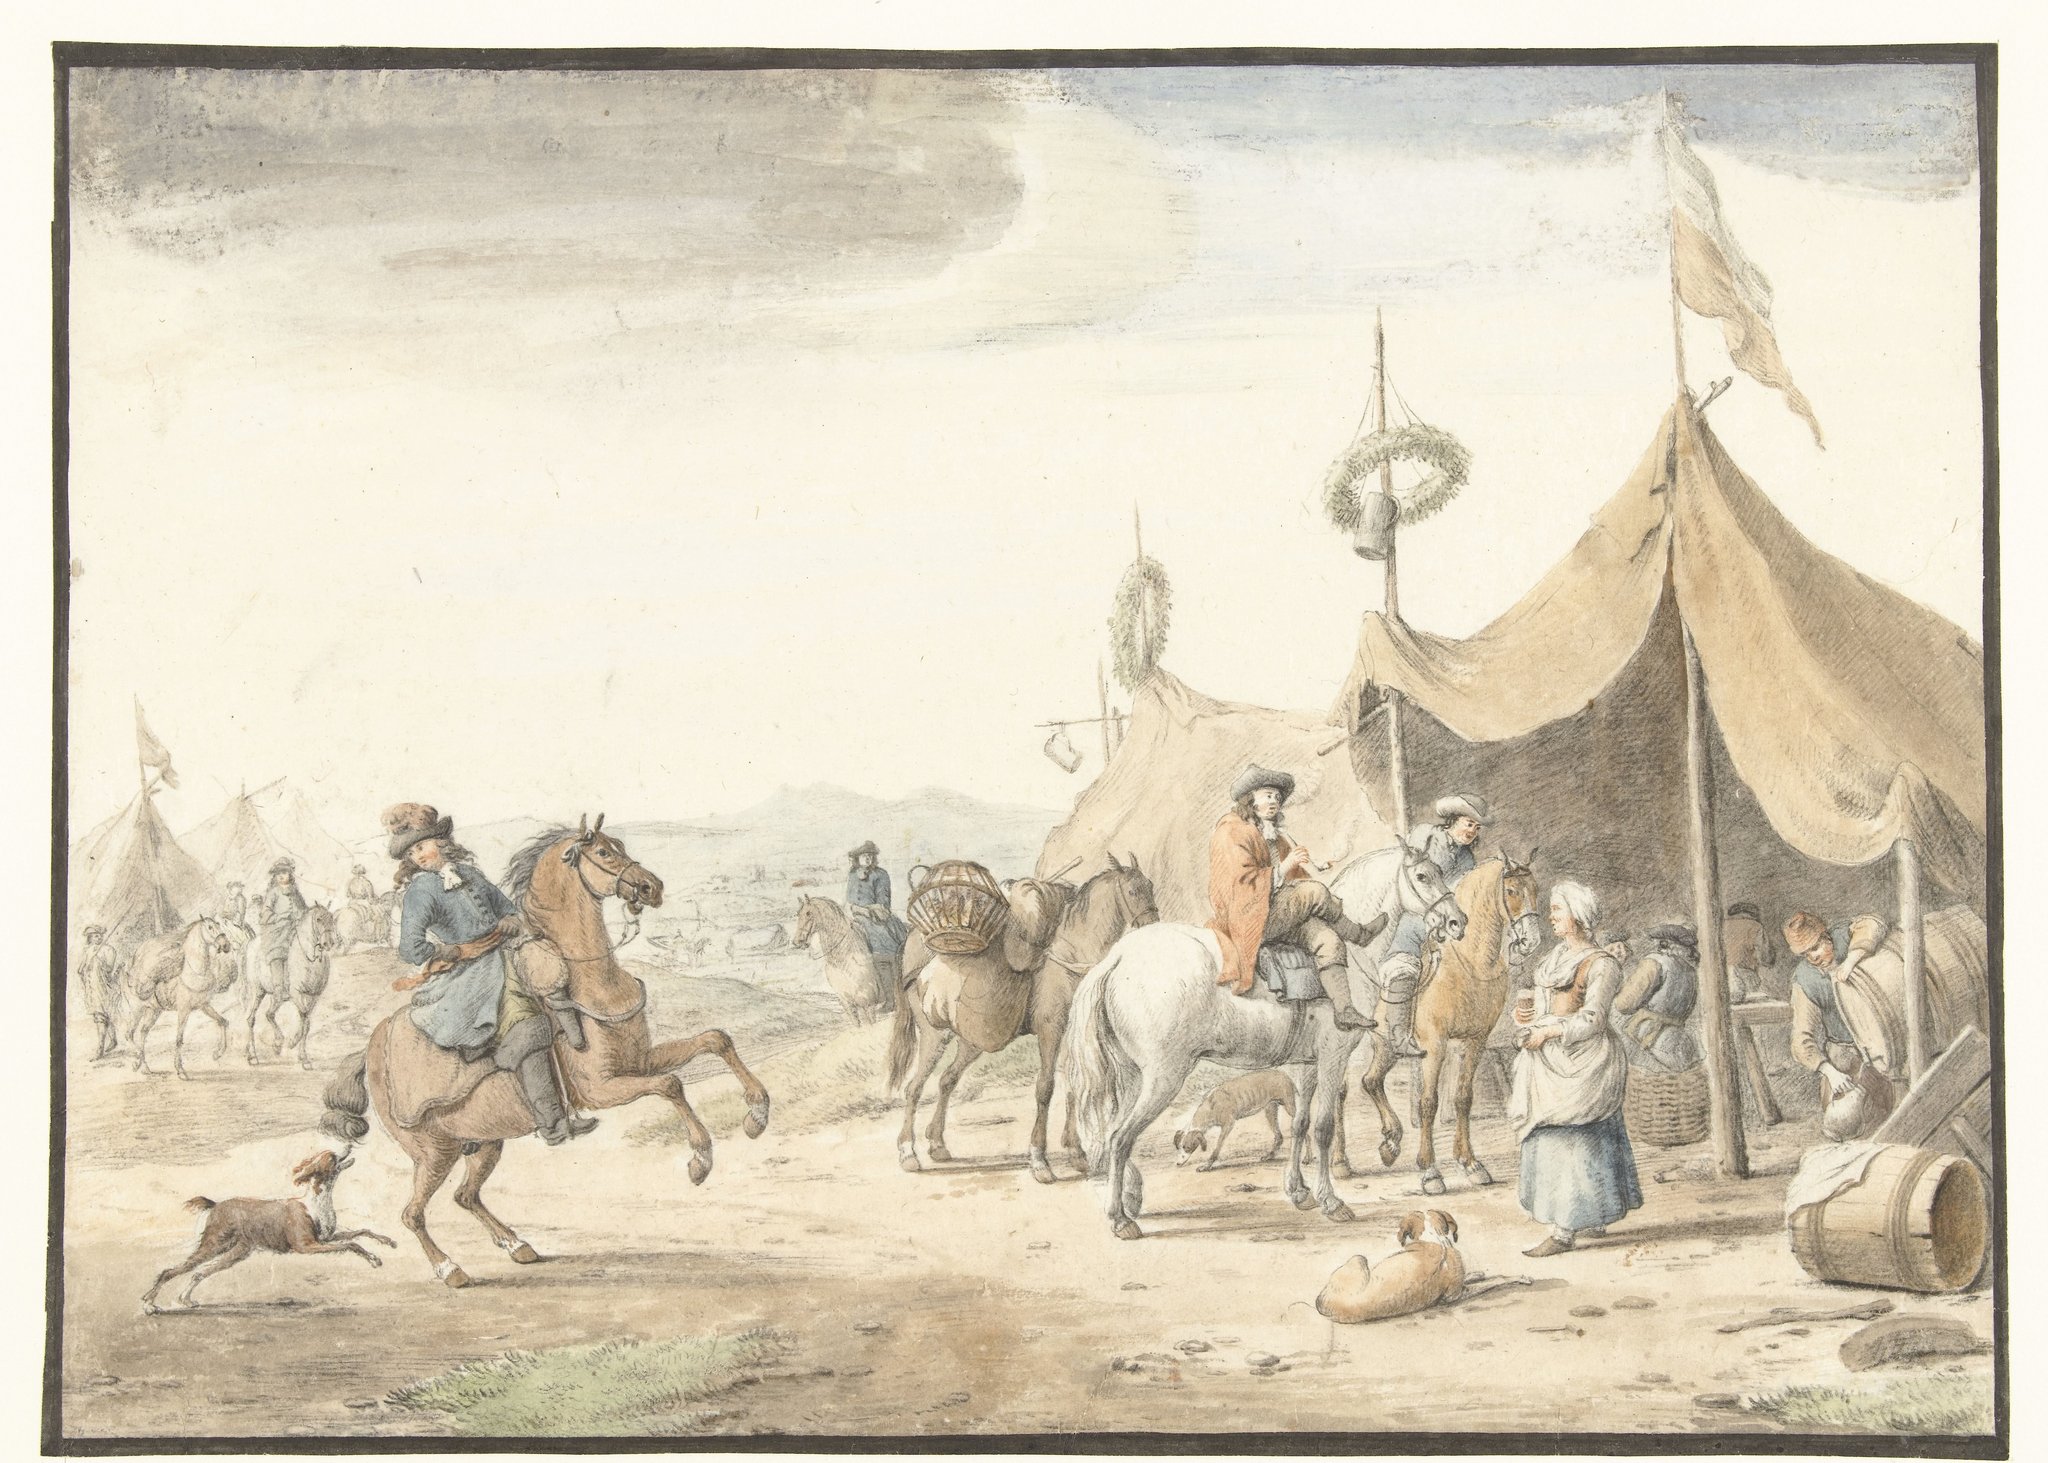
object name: drawing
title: Legerkamp met ruiters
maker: jan vincentsz. van der vinne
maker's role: draughtsman, print maker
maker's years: 1663-1721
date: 1673-1721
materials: chalk, paint, paper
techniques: brush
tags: (military) camp with tents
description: Pendant van de gesigneerde tekening, lot nr. 379 op de veiling (Mak van Waay, 26/09/1972). Alleen lot nr. 378 in RPK.